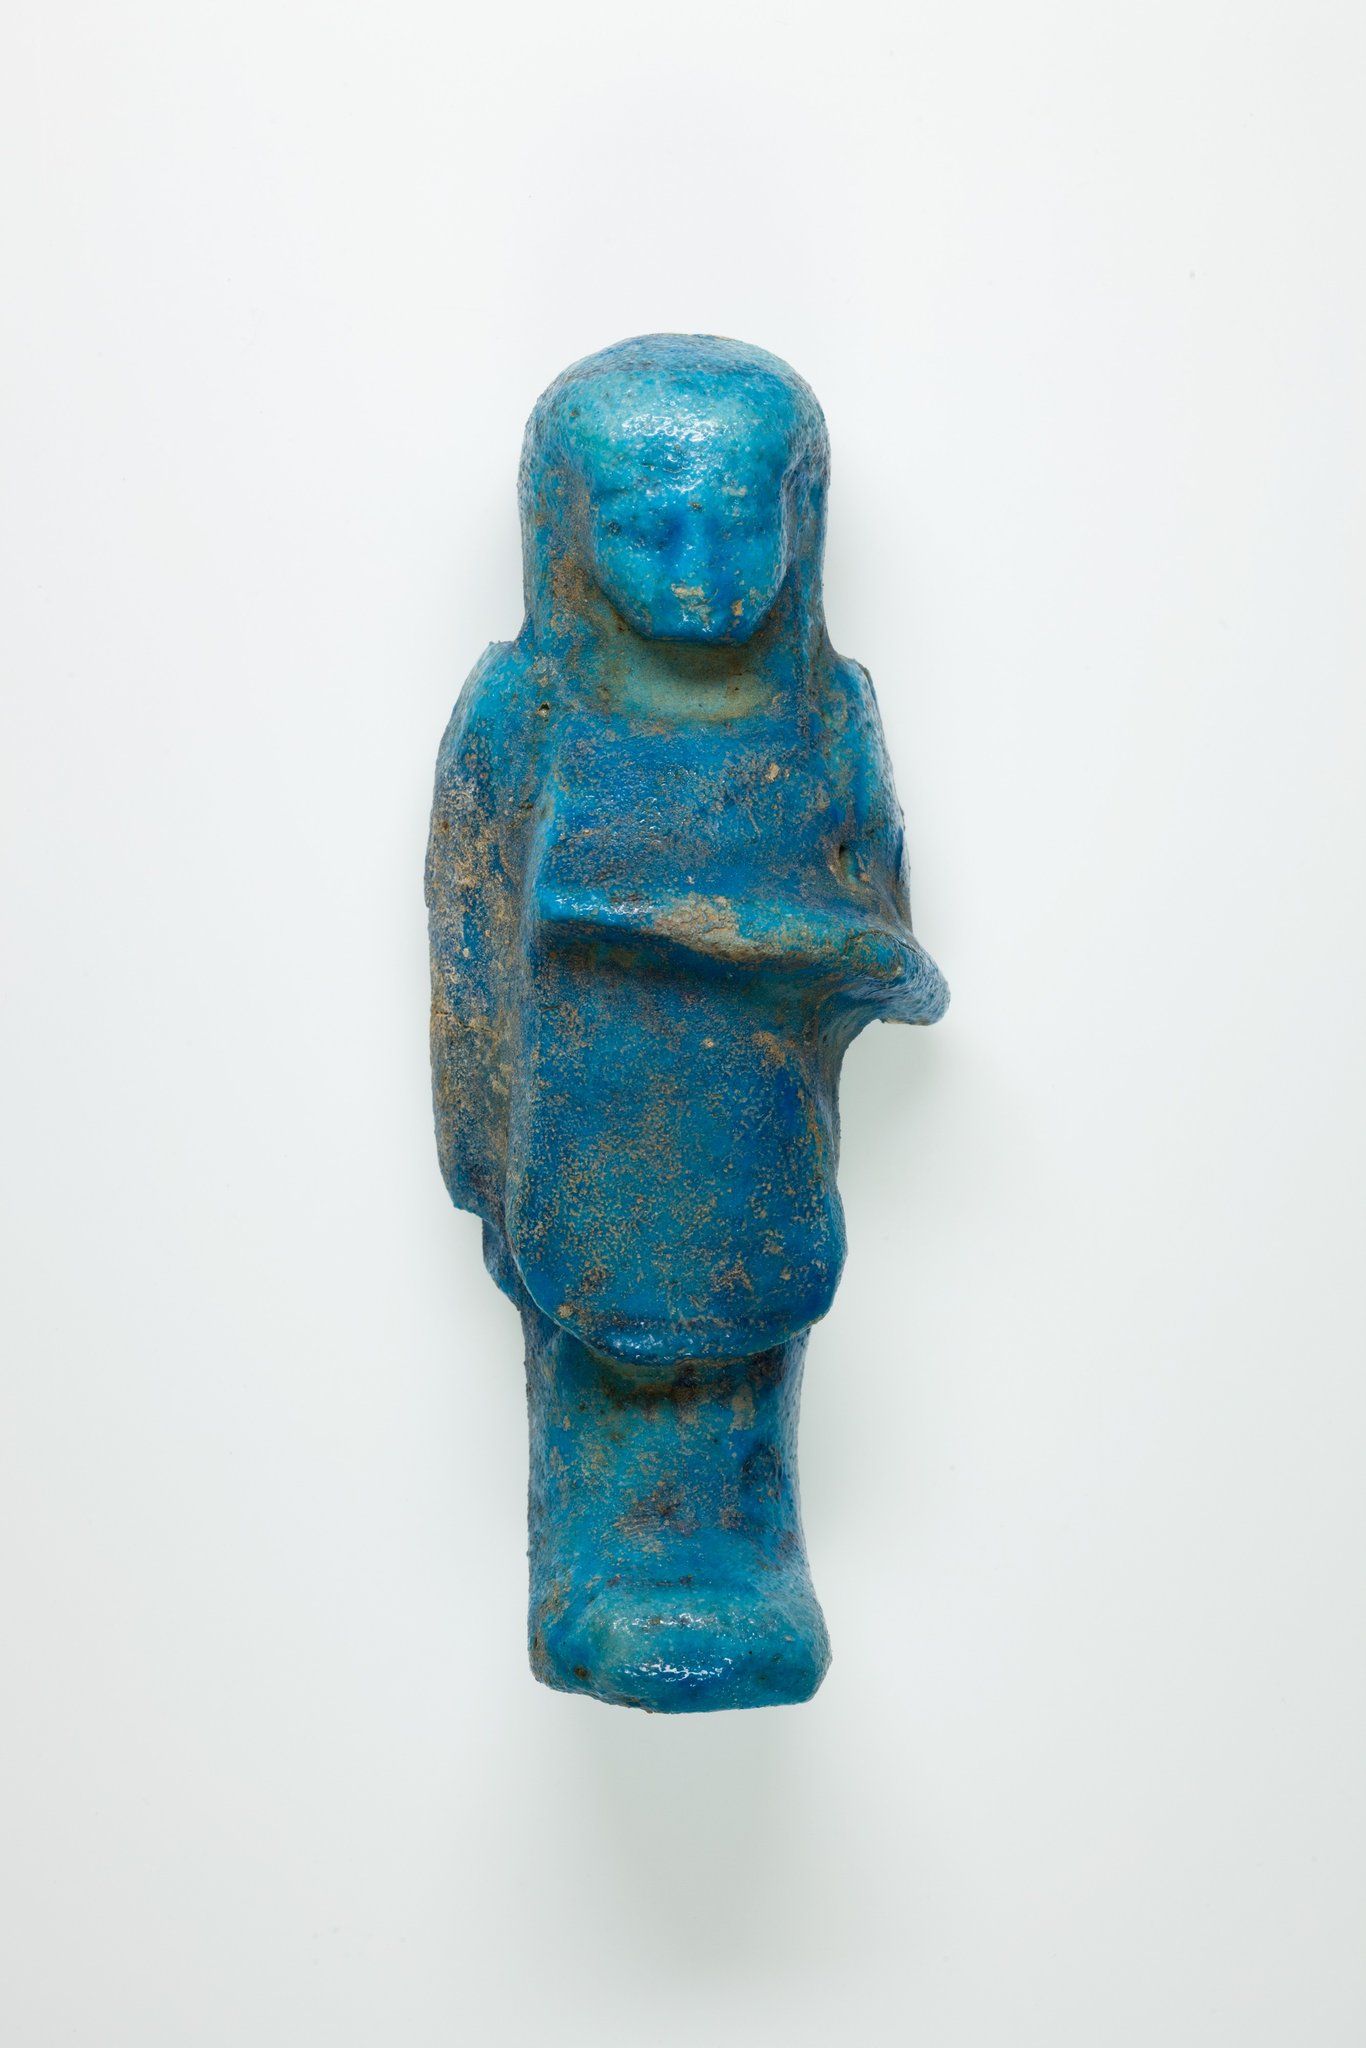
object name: overseer shabti, henettawy c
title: Overseer Shabti of Henettawy (C), Daughter of Isetemkheb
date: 990-970 BCE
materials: faience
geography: egypt